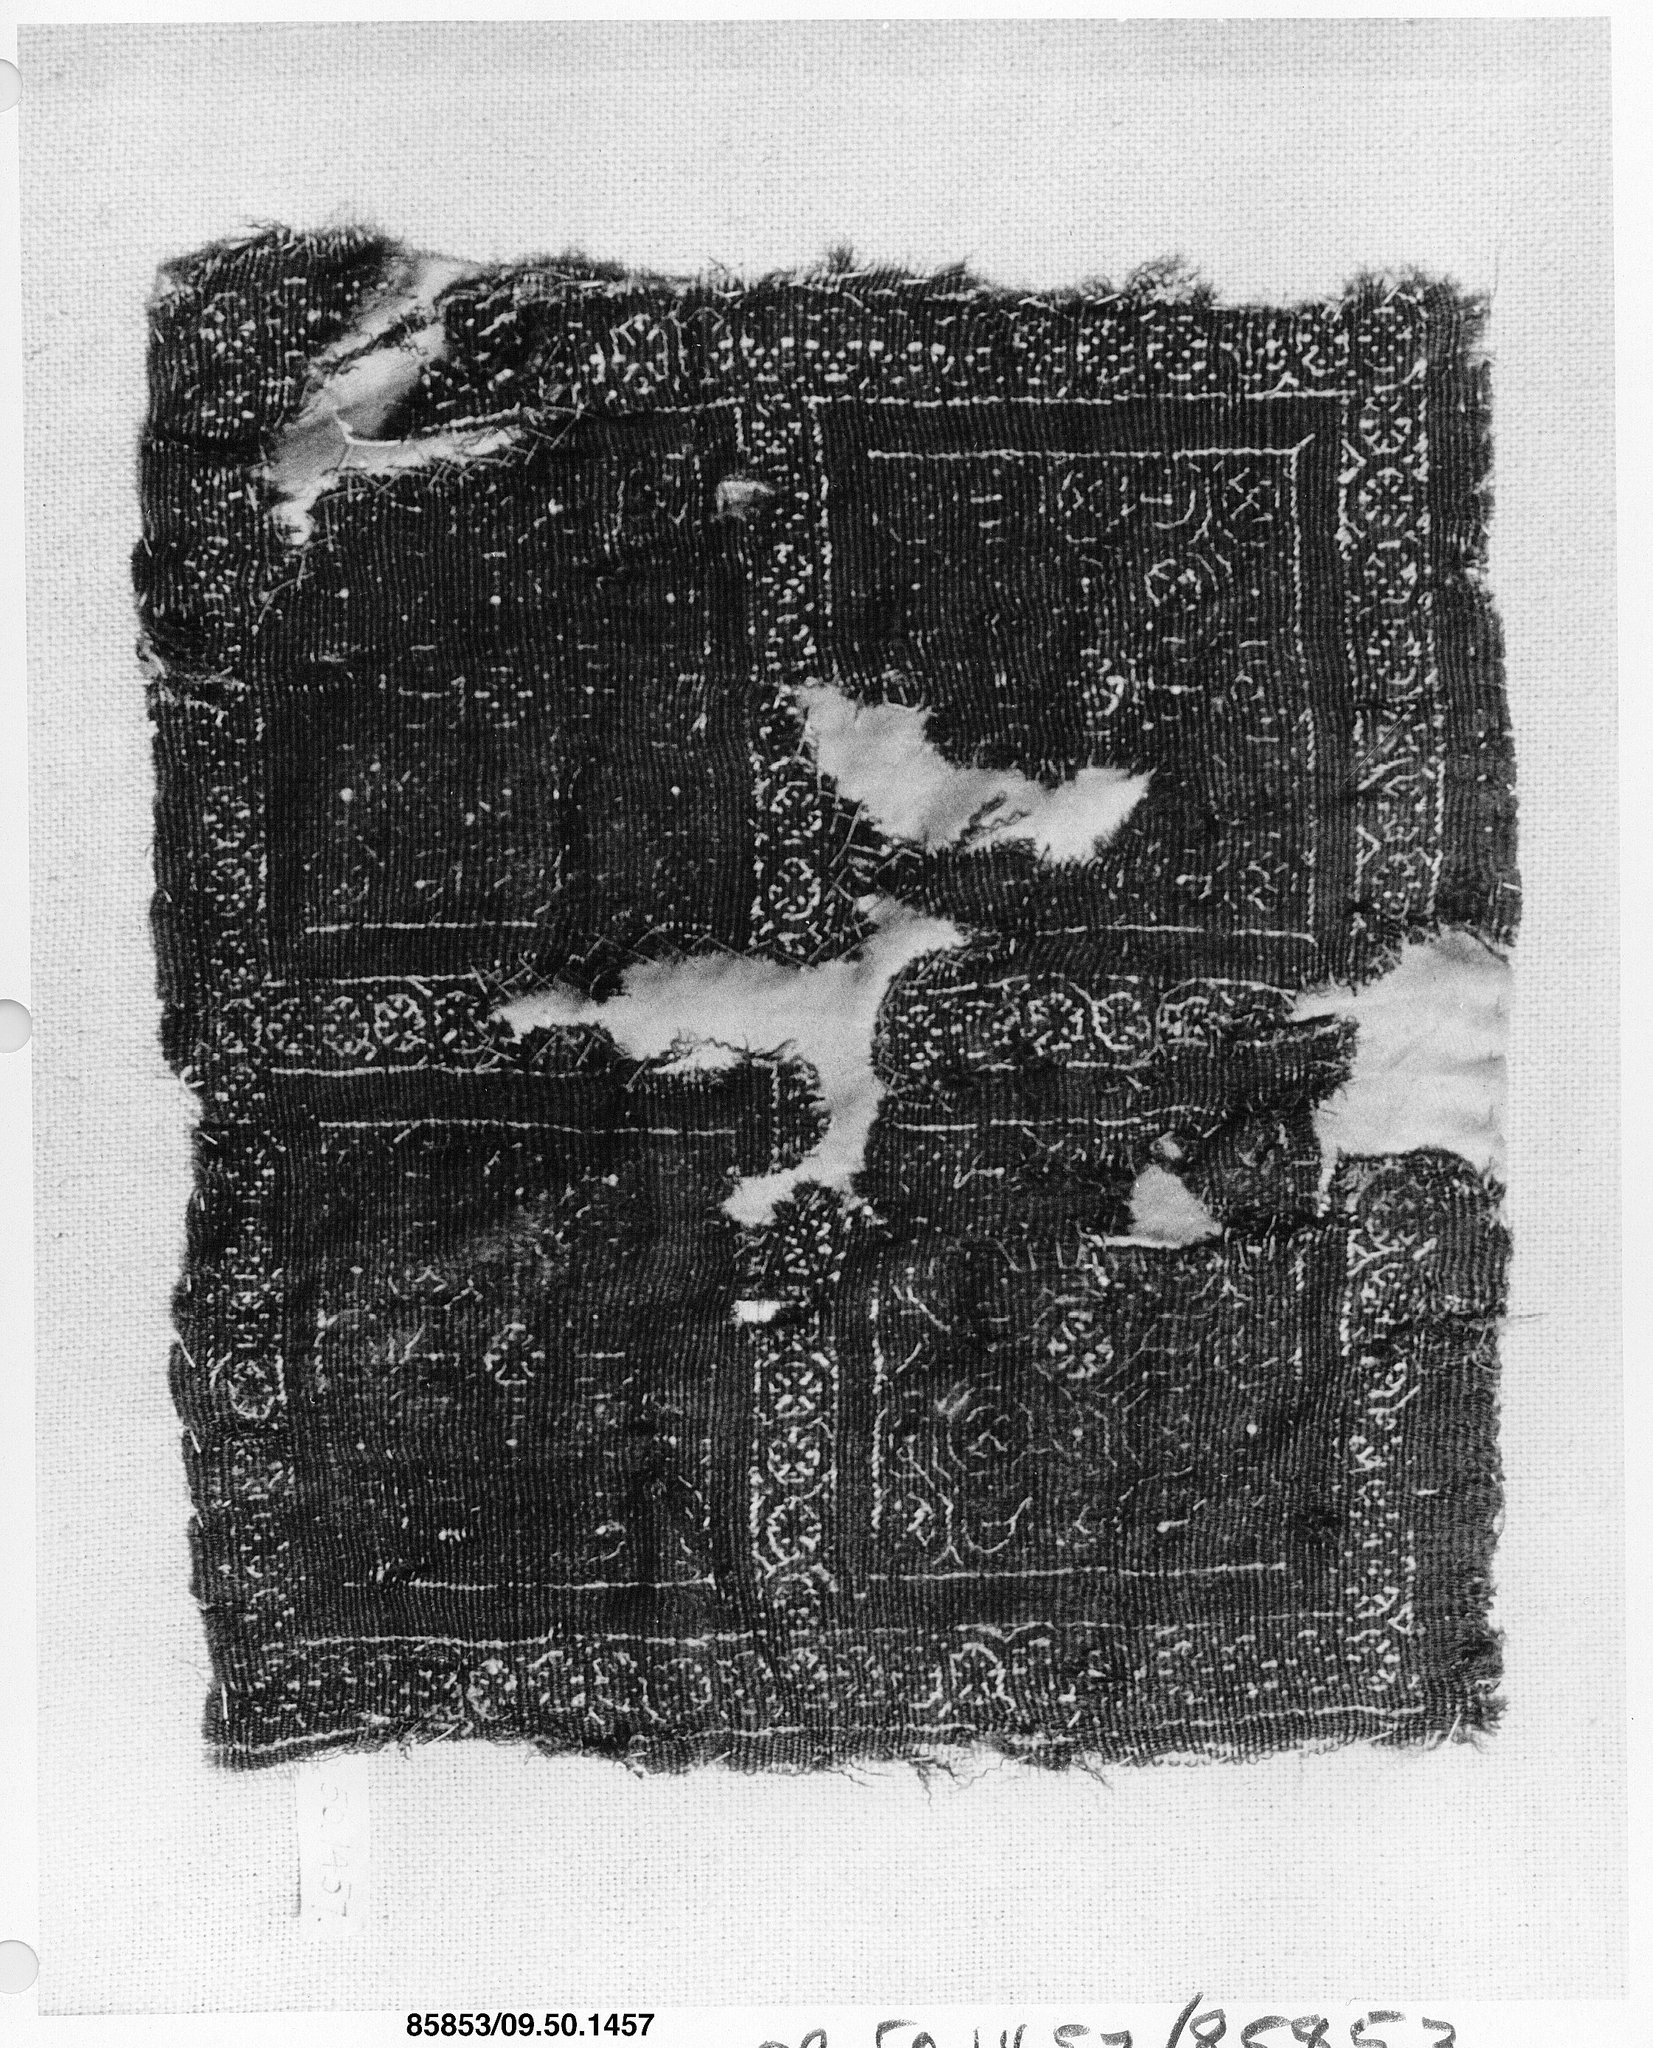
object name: square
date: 201-400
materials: linen, wool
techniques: weave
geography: egypt